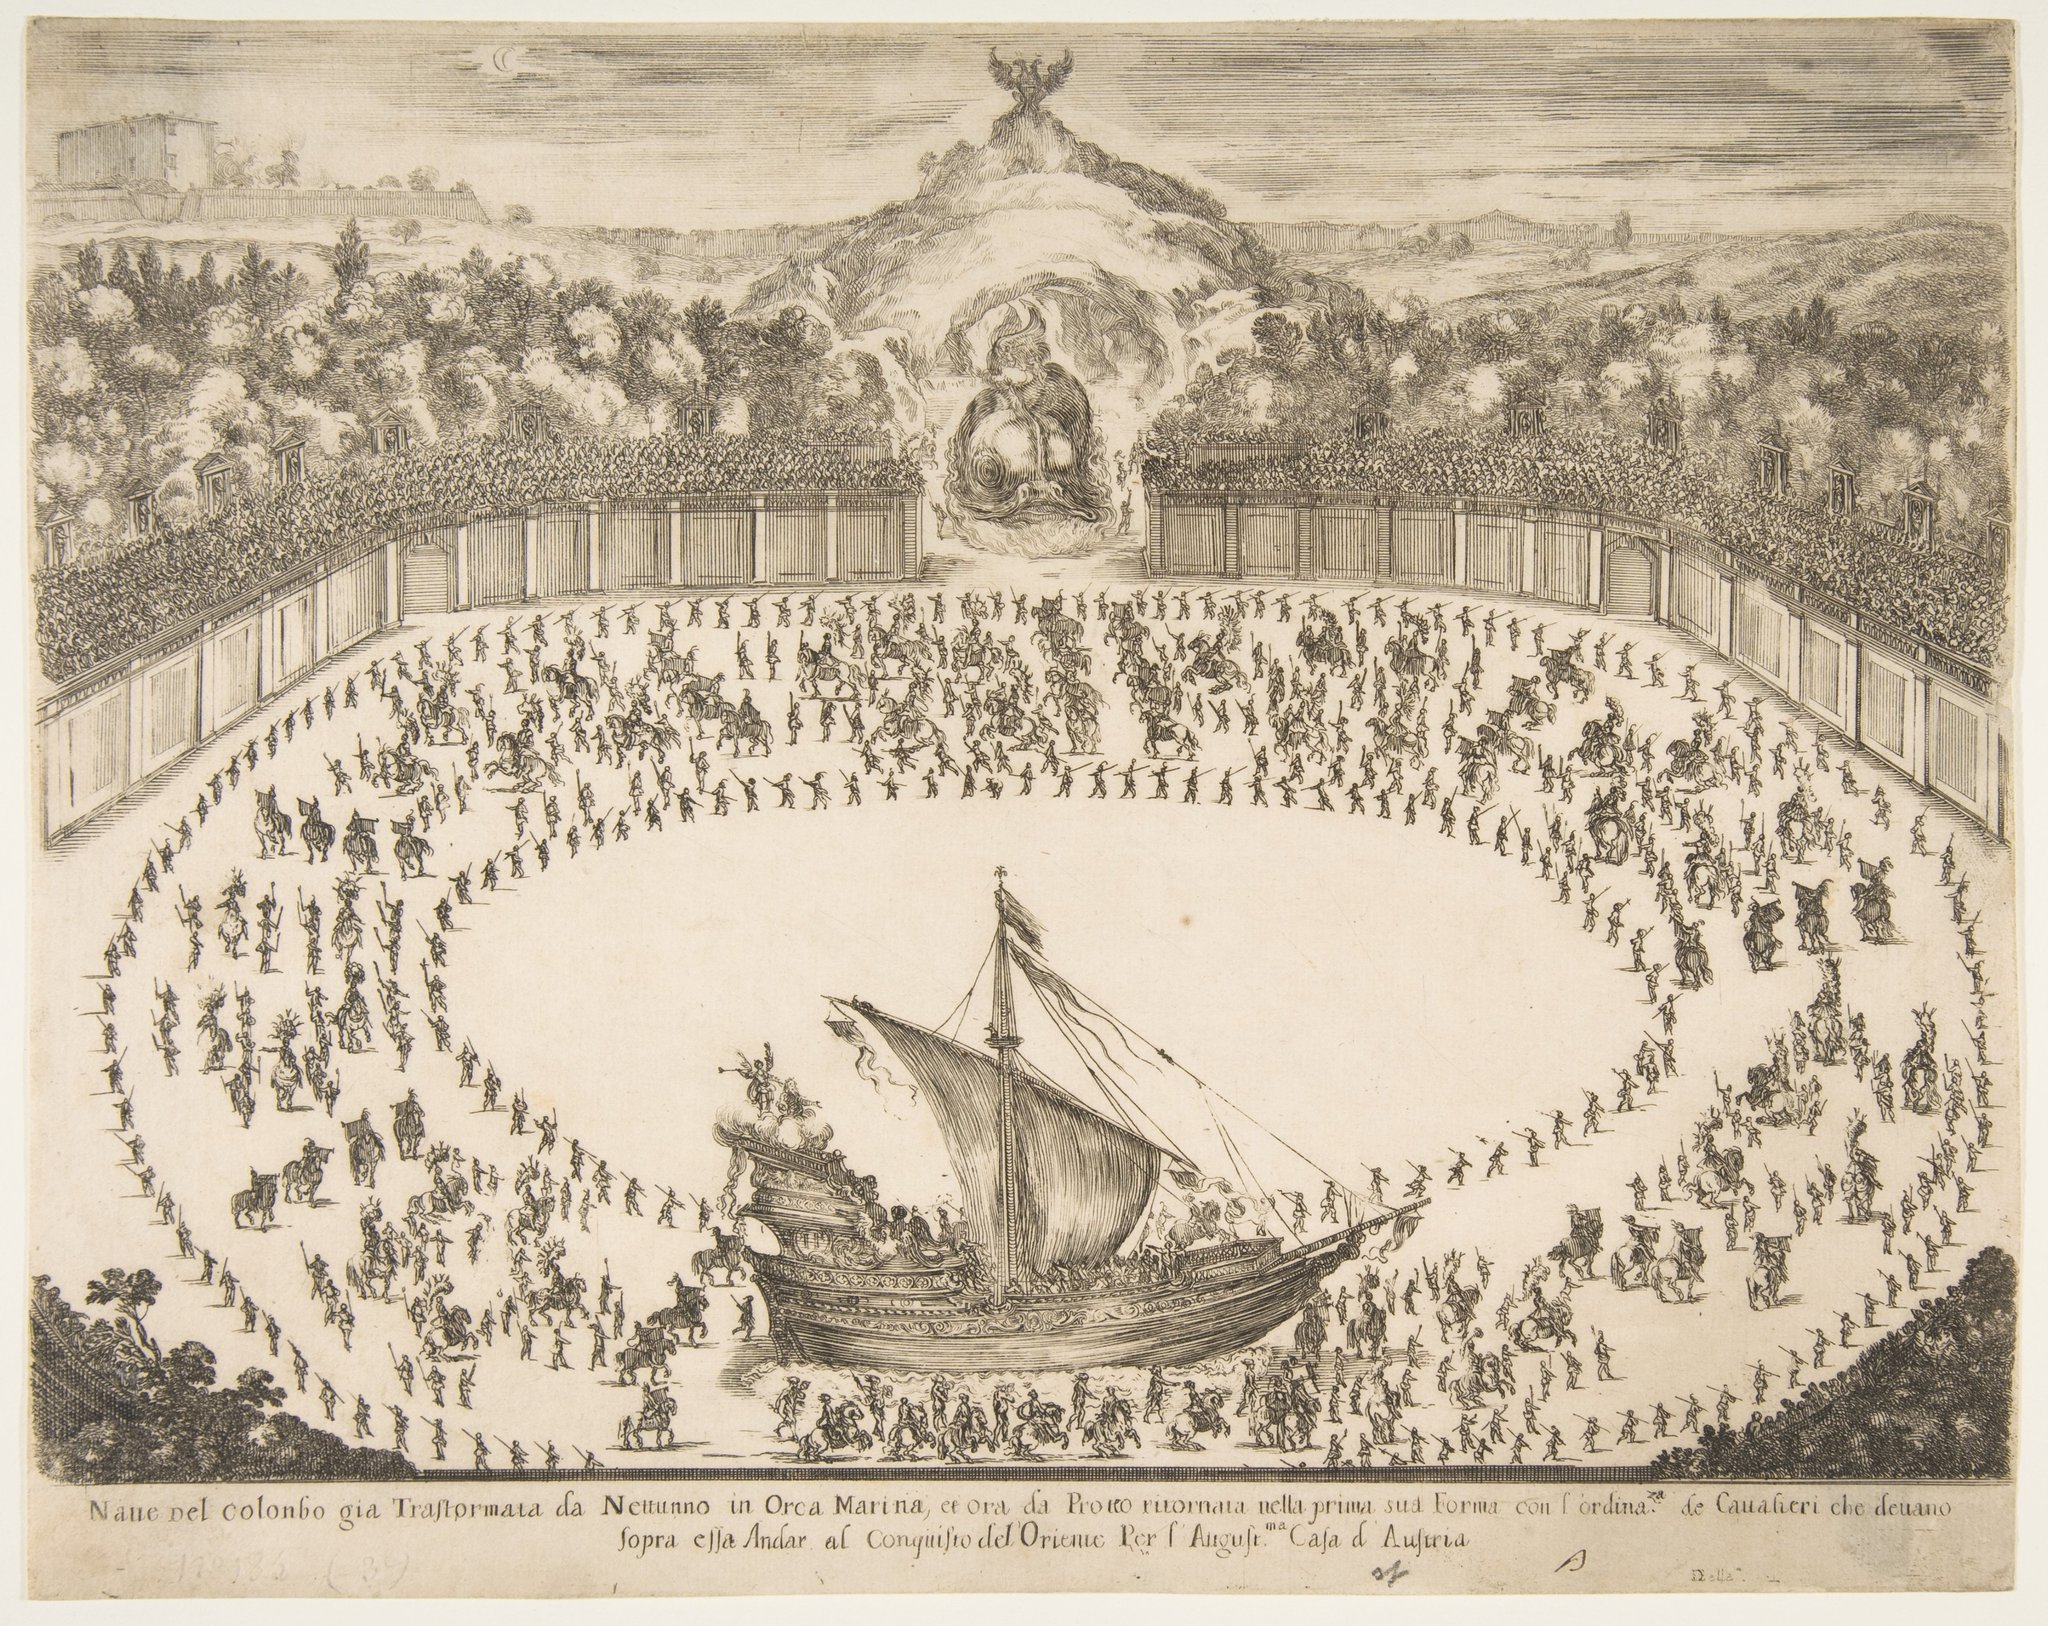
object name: print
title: Parade float in the form of a ship, coat of arms of the Grand Duke of Modena at top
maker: stefano della bella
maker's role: artist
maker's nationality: italian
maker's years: 1610-1664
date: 1652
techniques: engraving, etching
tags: horses,crowd,ships